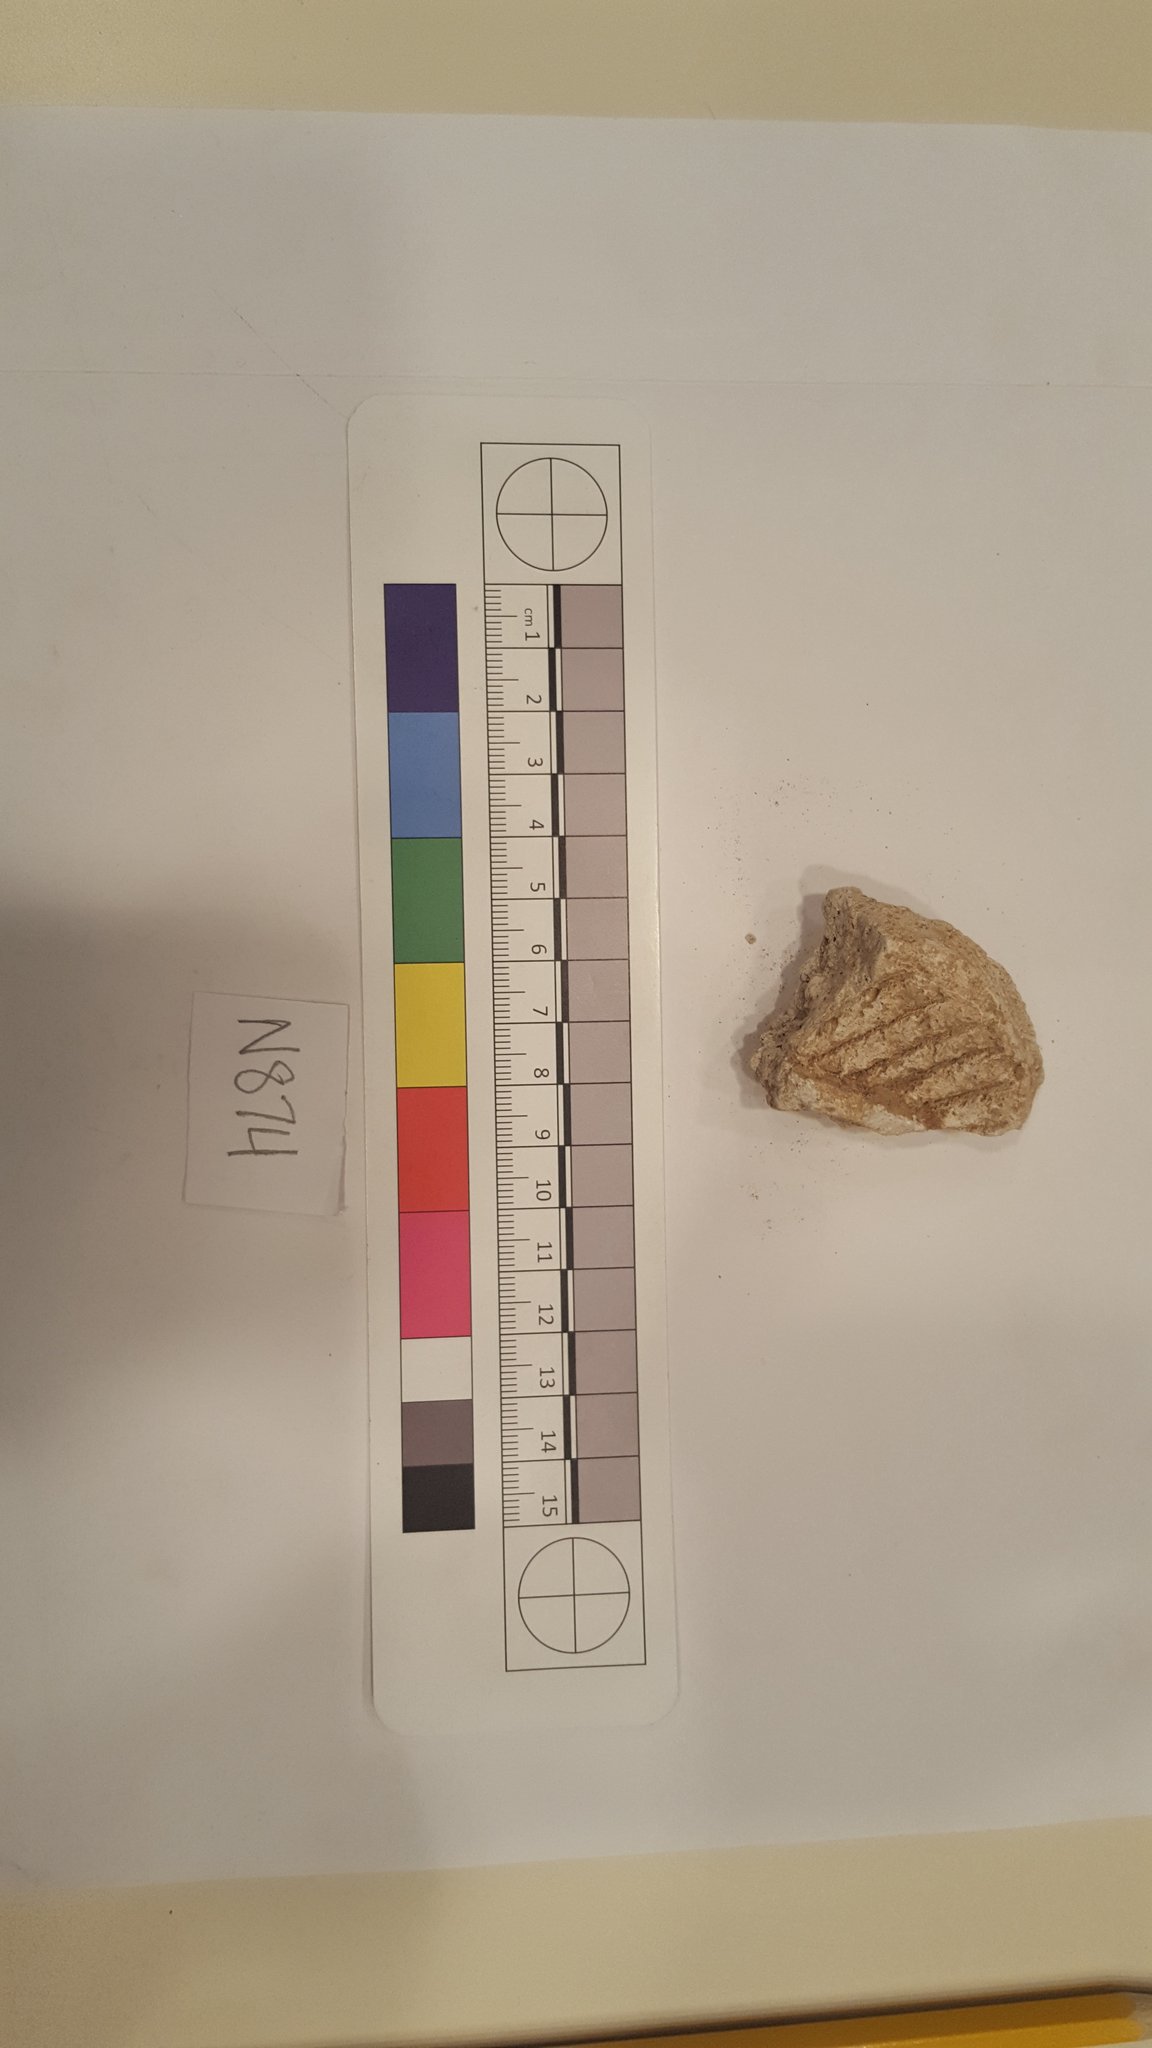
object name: fragment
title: Stucco Fragment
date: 701-1200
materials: plaster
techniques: carving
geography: iran